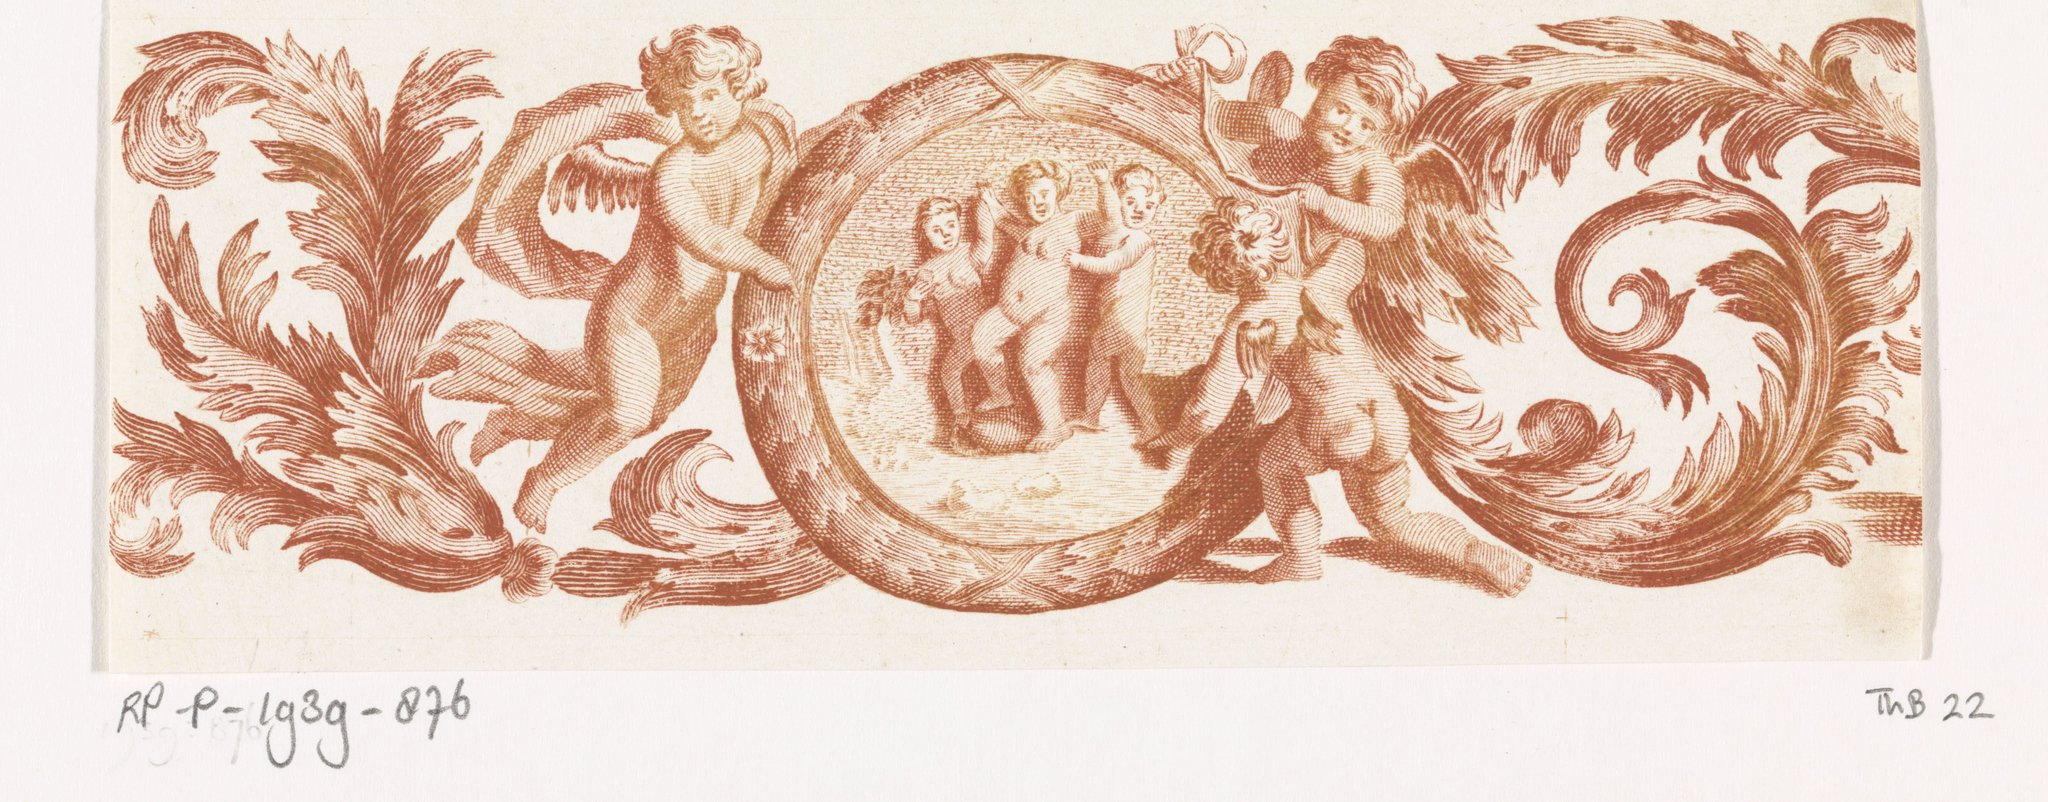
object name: print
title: Bladornament met putti (linker deel)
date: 1688-1698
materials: paper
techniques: printing, engraving, lithography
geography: netherlands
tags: foliage, tendrils, branches ~ ornament, cupids: 'amores', 'amoretti', 'putti'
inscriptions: collector's mark: Lugt 2228, collector's mark: Lugt 2760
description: Ornamentele bladmotieven en drie putti met een krans. In het midden van de krans een voorstelling van drie andere putti.